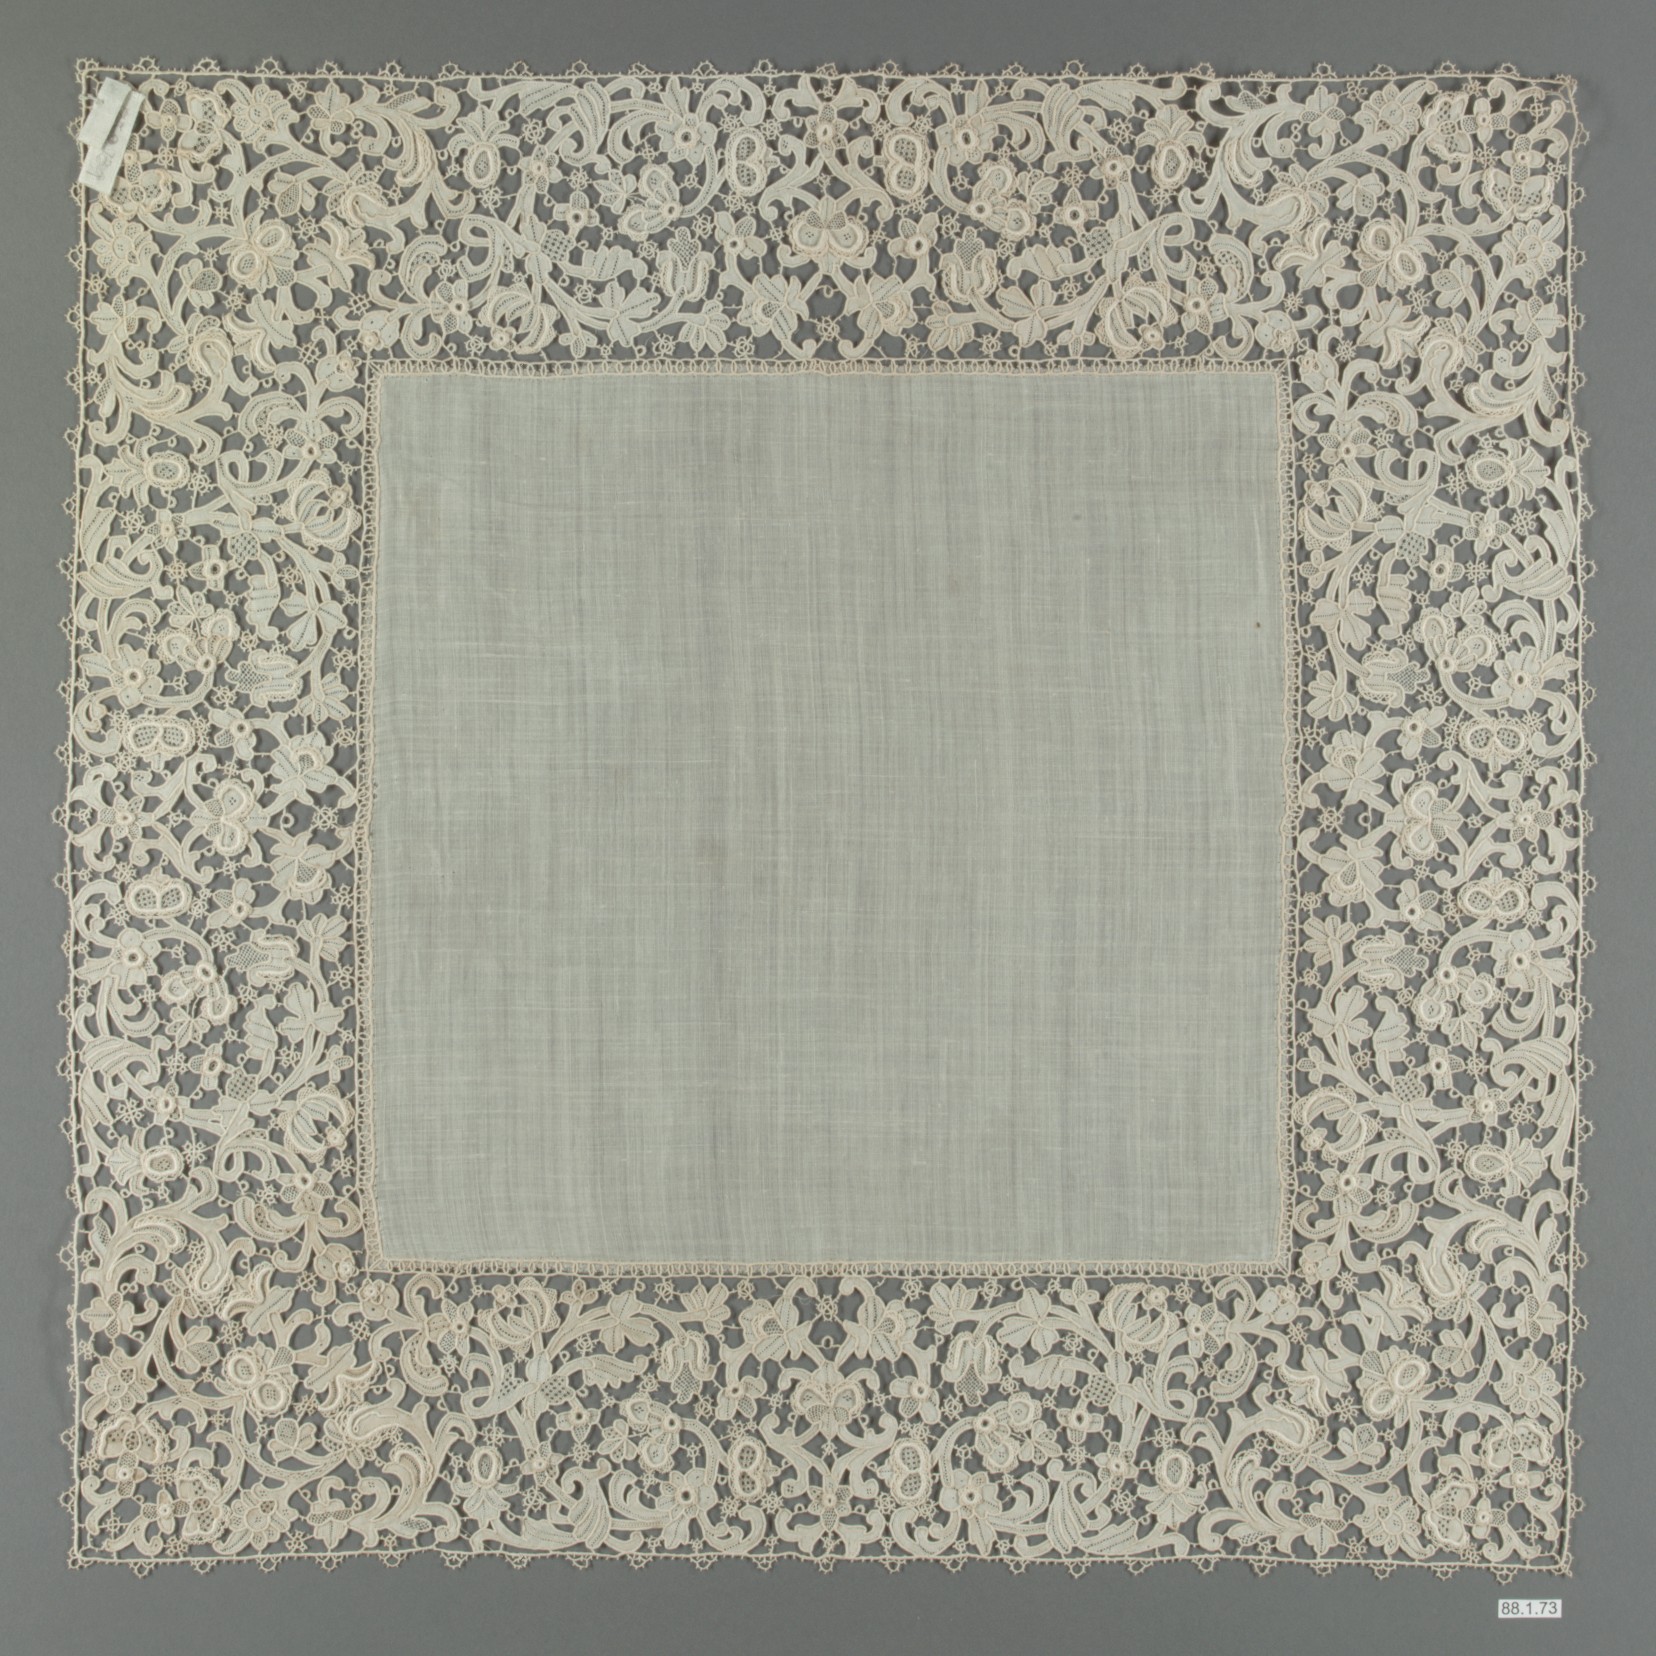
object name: handkerchief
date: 1801-1900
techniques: lace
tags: flowers